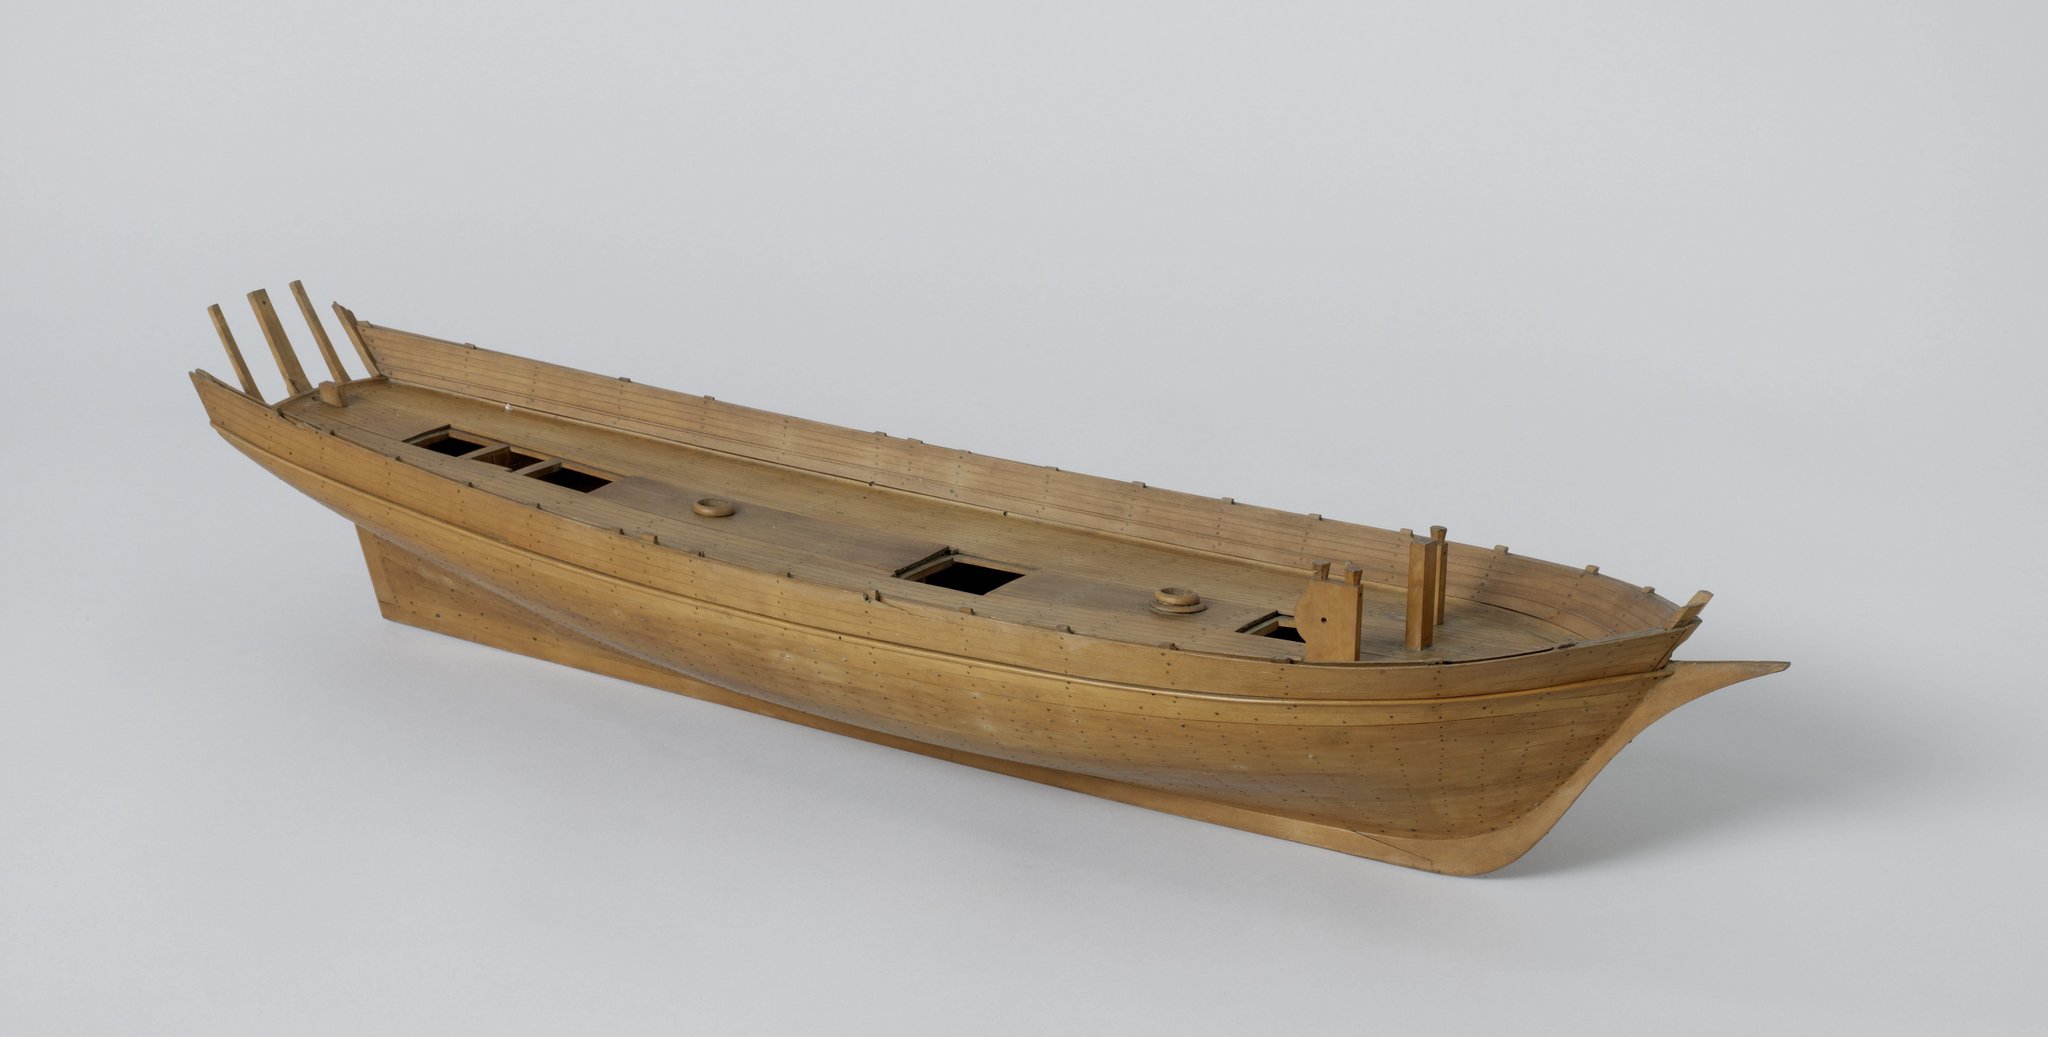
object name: hull model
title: Model of a Two-Masted Ship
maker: Anonymous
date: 1800-1850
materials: wood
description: Model van de romp van een schip, de twee masten en opbouw ontbreken evenals het hek.